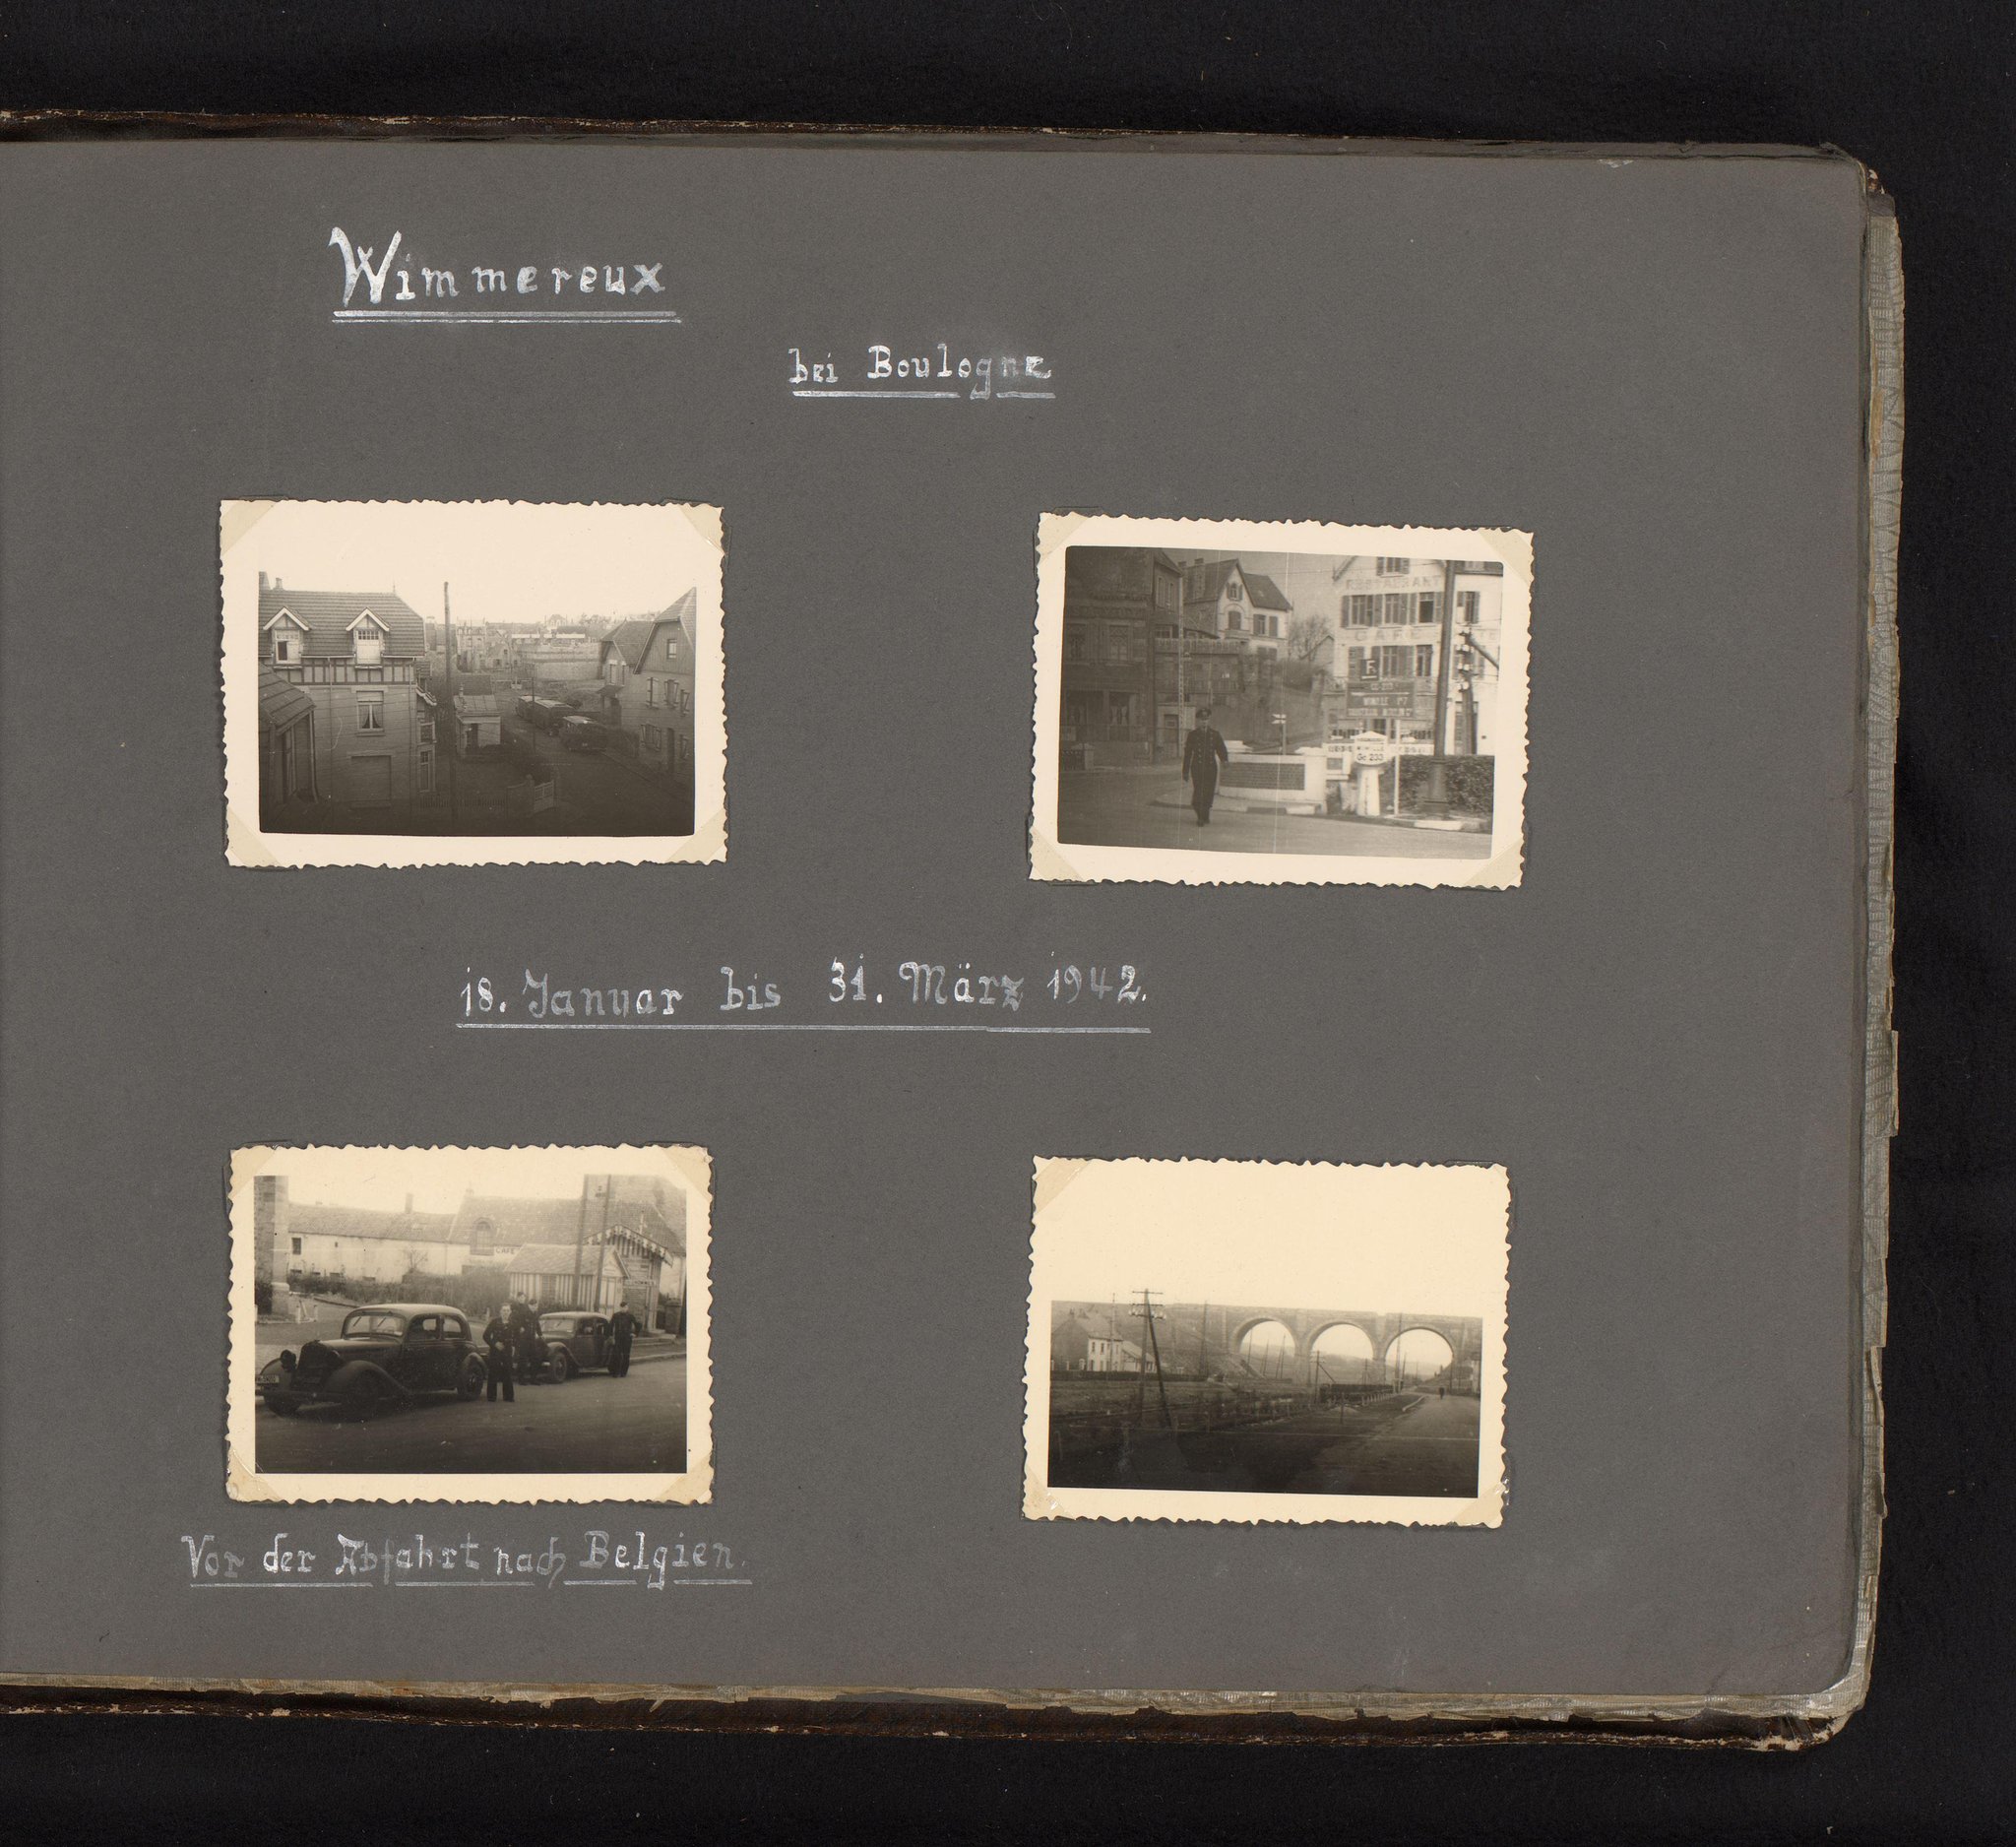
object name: photograph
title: Kriegsmarine in Wimereux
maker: Anonymous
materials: paper, photographic support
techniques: gelatin silver print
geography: wimereux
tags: the company, the unit, the troop ~ military service, city-view in general; 'veduta', sailor, automobile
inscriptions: inscription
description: Albumblad met vier foto's met gezichten te Wimereux, waar deze eenheid van de Kriegsmarine was gestationeerd van 18 januari tot 31 maart 1942. Onderdeel van het fotoalbum Kriegsmarine.